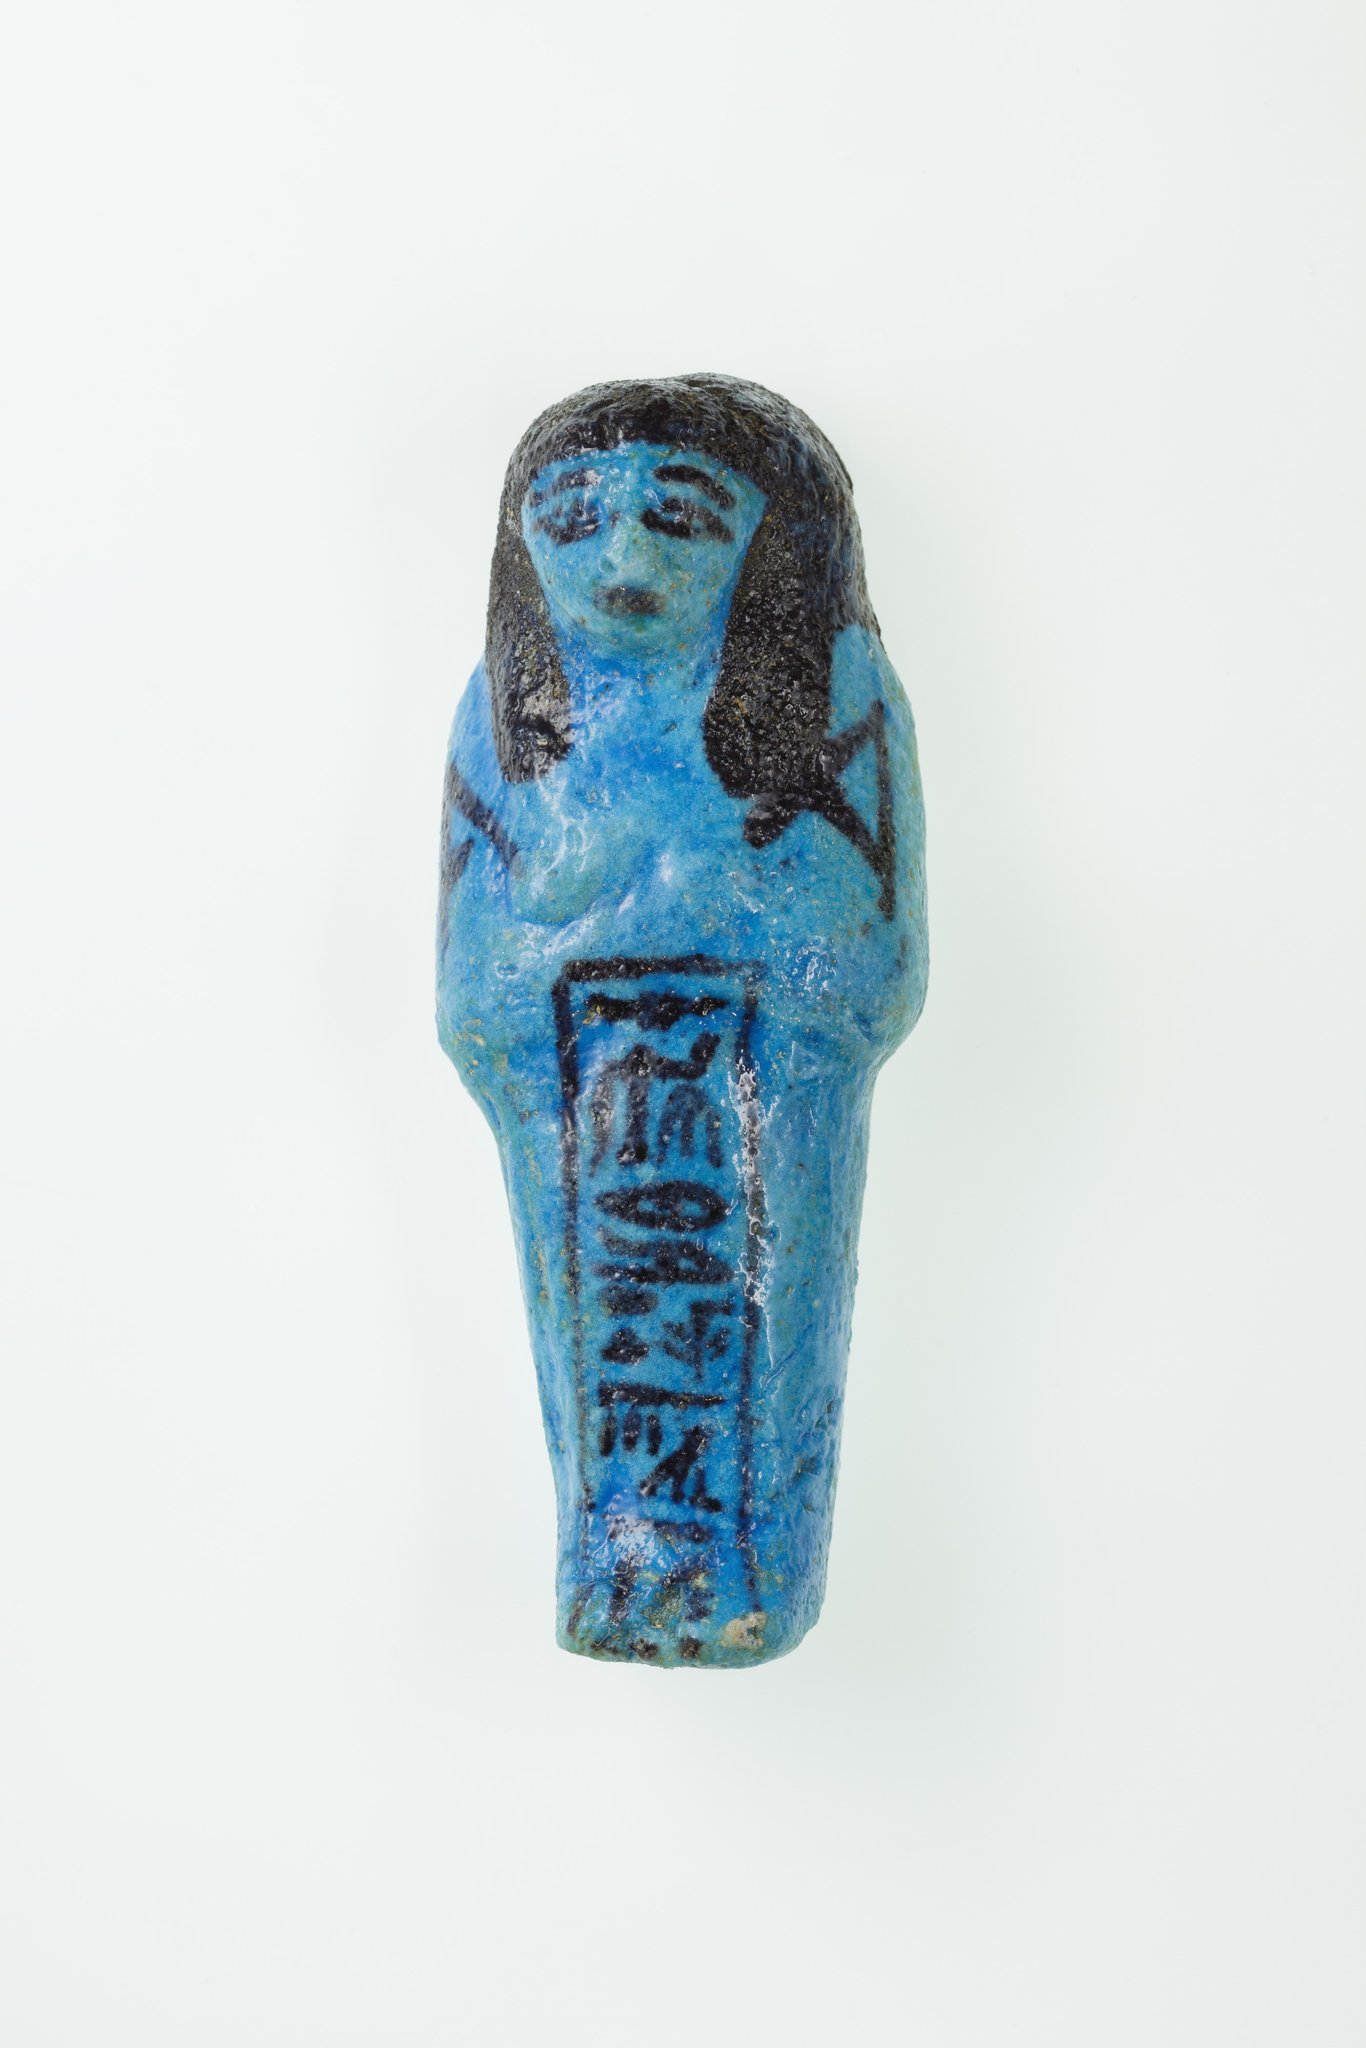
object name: shabti, worker, nauny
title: Worker Shabti of Nauny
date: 1050 BCE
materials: faience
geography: egypt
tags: hieroglyphs